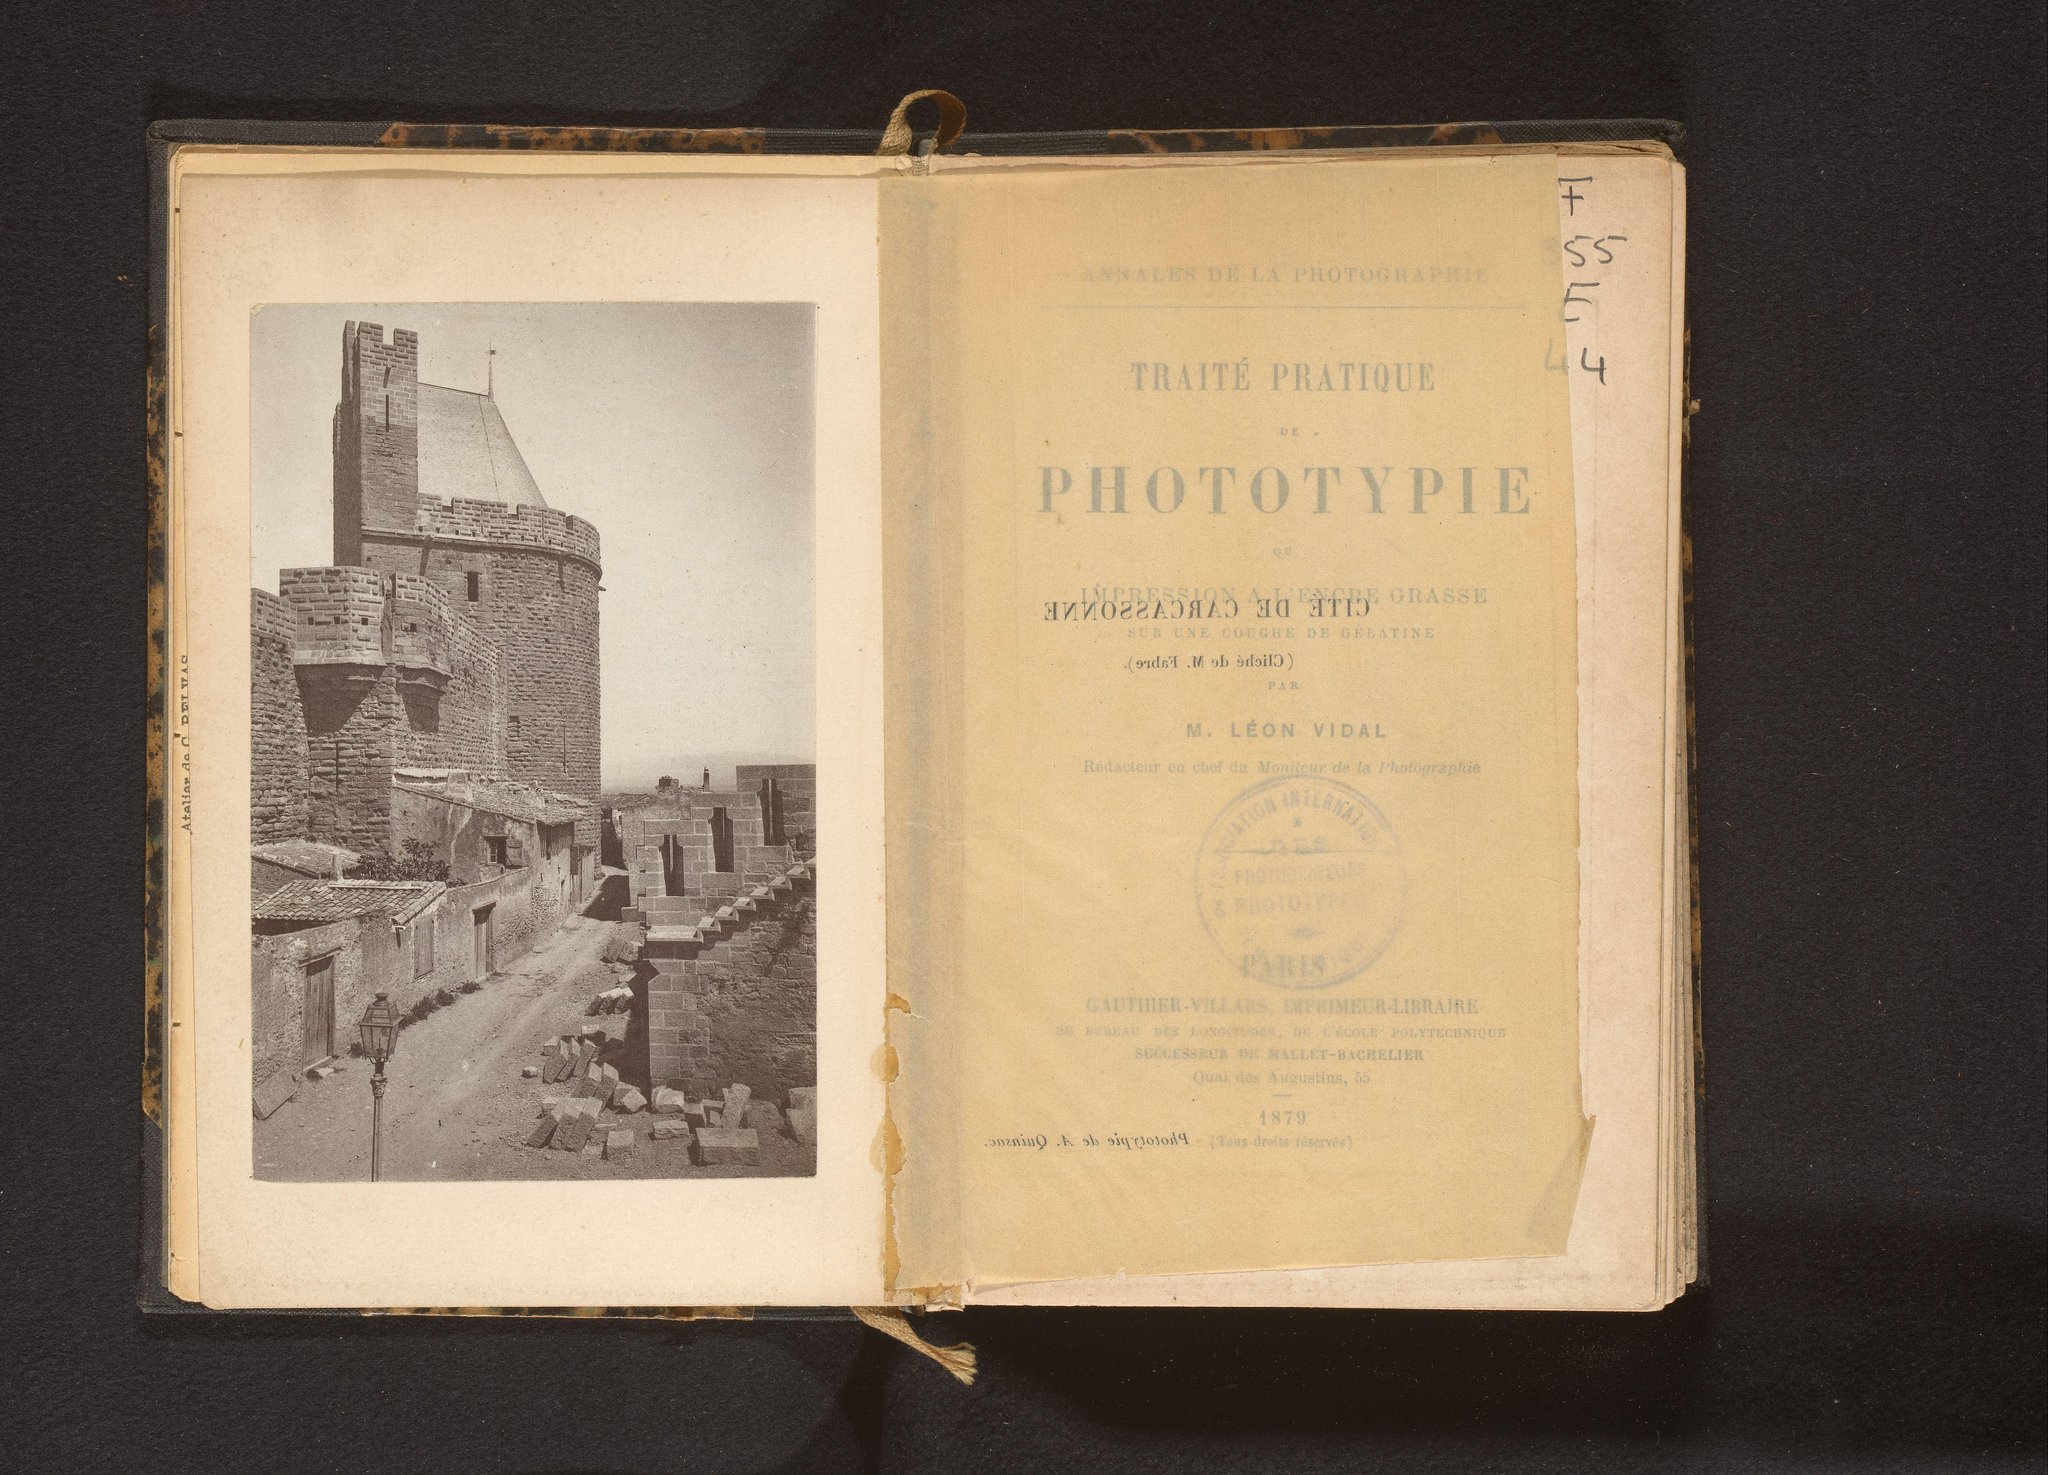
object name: page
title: Gezicht op de Cité de Carcassonne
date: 1869-1879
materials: paper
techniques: photograph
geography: carcassonne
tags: tower, clock tower ~ monumental adornment, castle